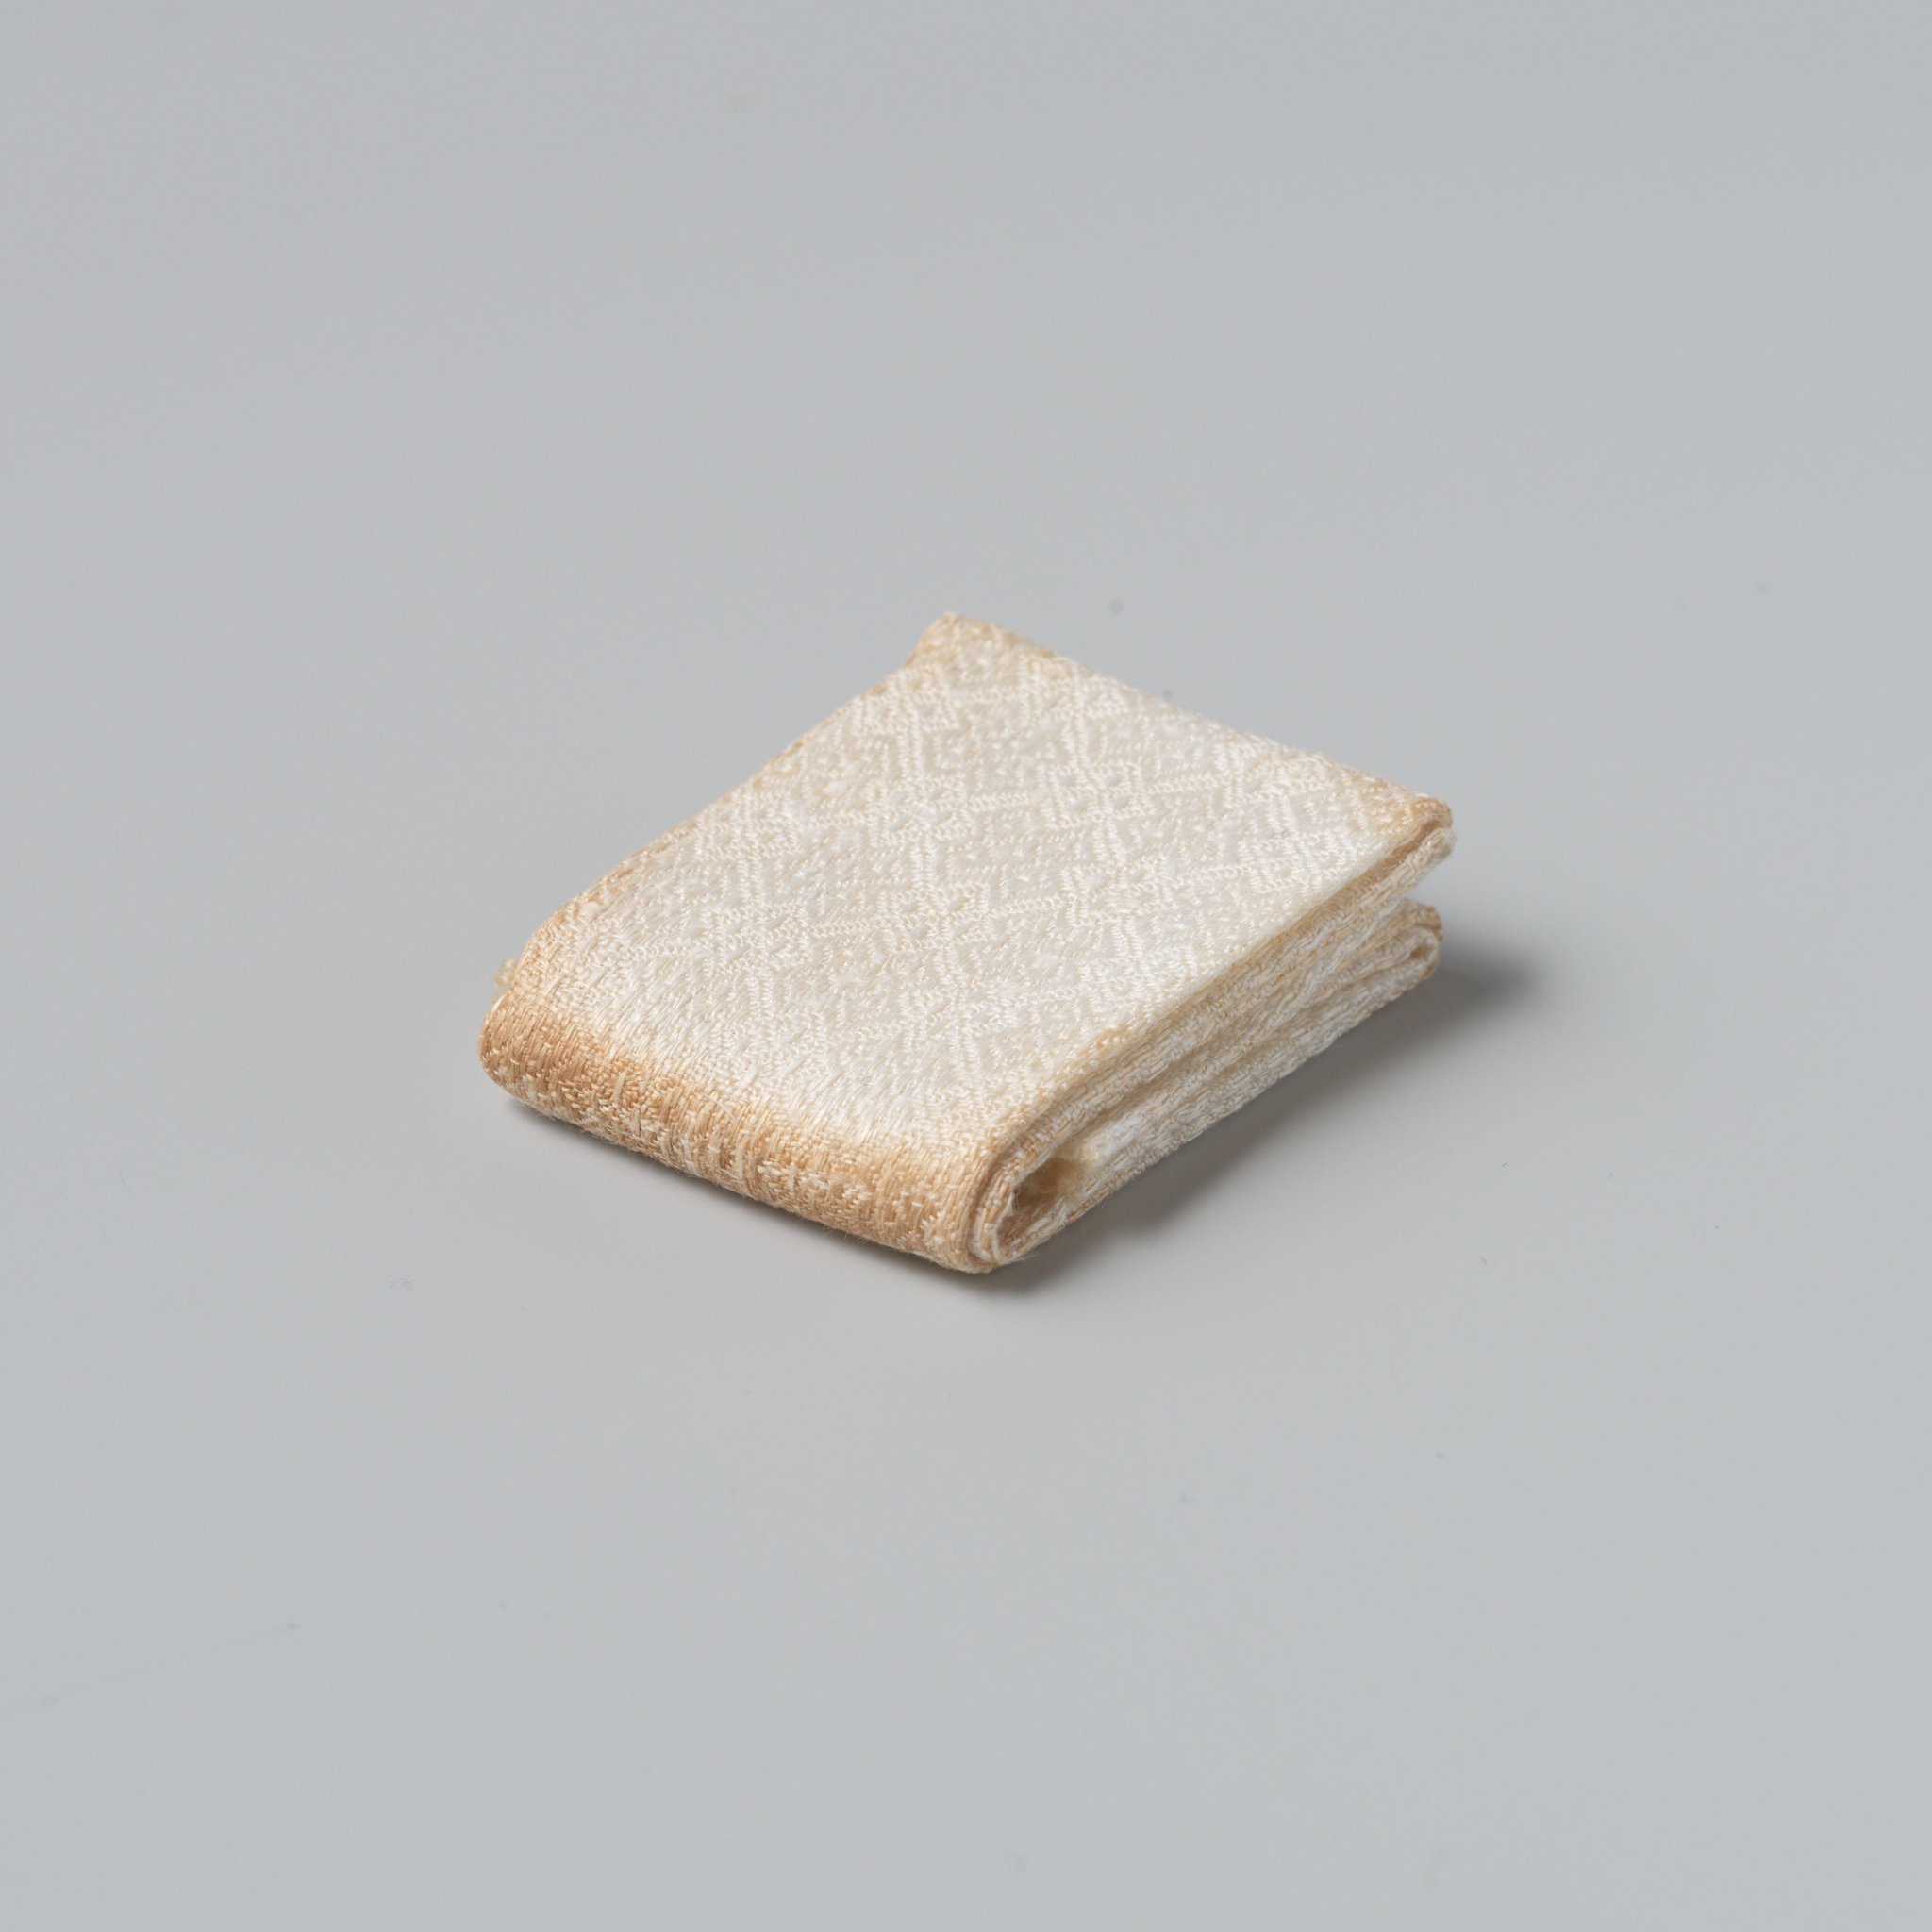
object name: tablecloth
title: Tafellaken, servet of handdoek van linnen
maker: Anonymous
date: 1600-1699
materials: linen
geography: netherlands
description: Tafellaken, servet of handdoek van linnen met een pellenpatroon, geknipt uit een groter stuk linnen. Geen zomen.